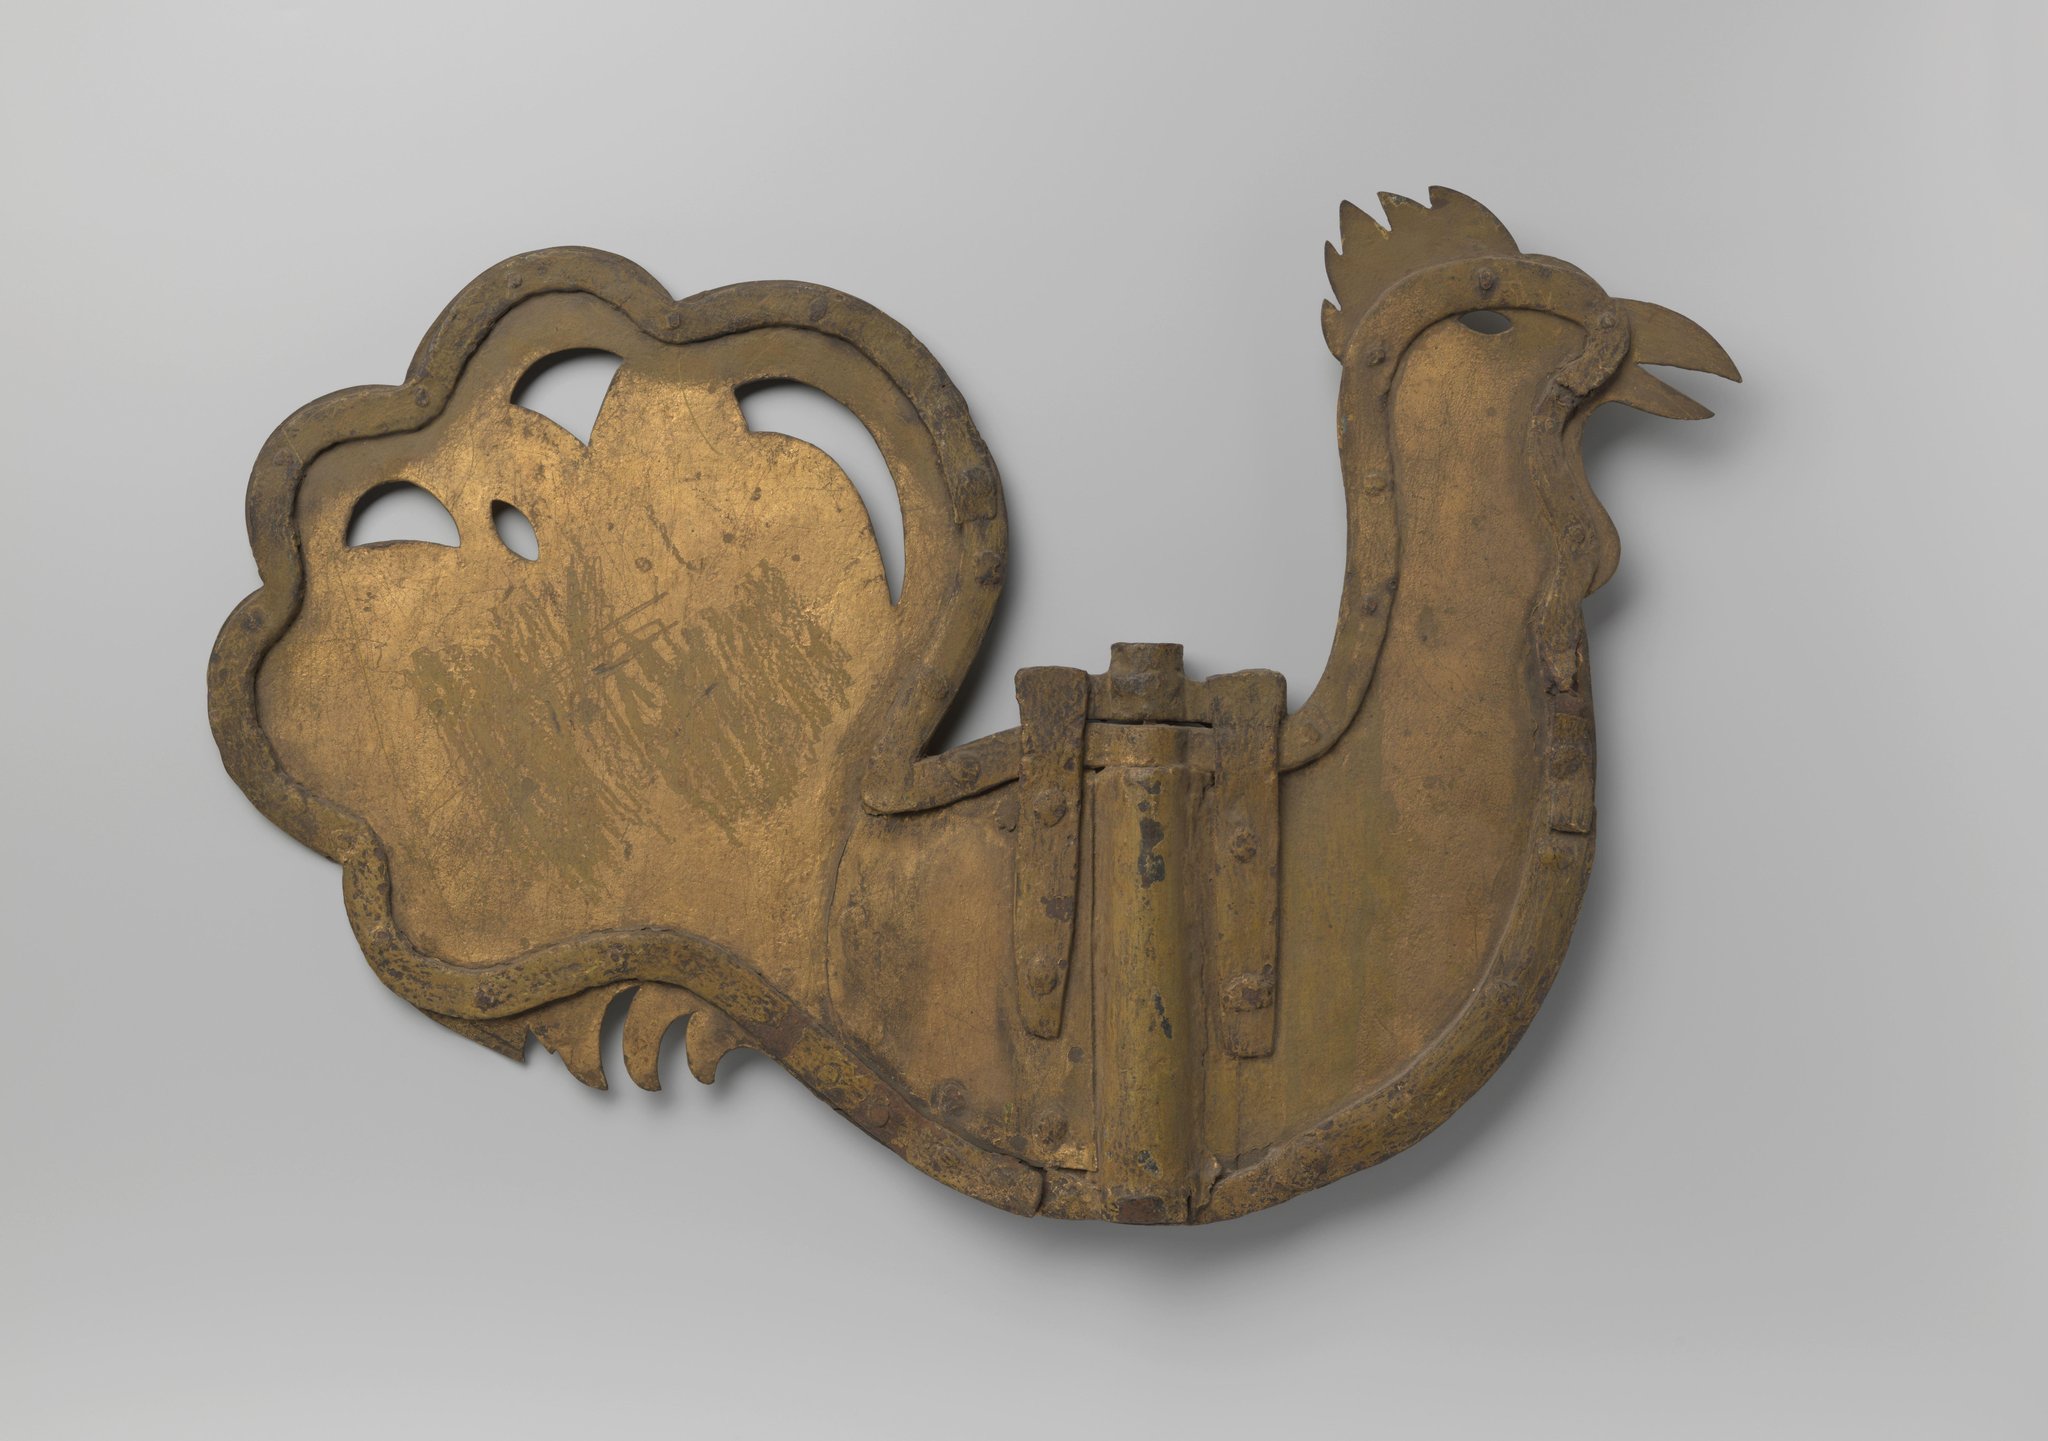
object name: weather vane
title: Weerhaan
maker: Anonymous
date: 1400-1950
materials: copper, iron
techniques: gilding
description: Weerhaan behorend bij torenkruis van ijzer.